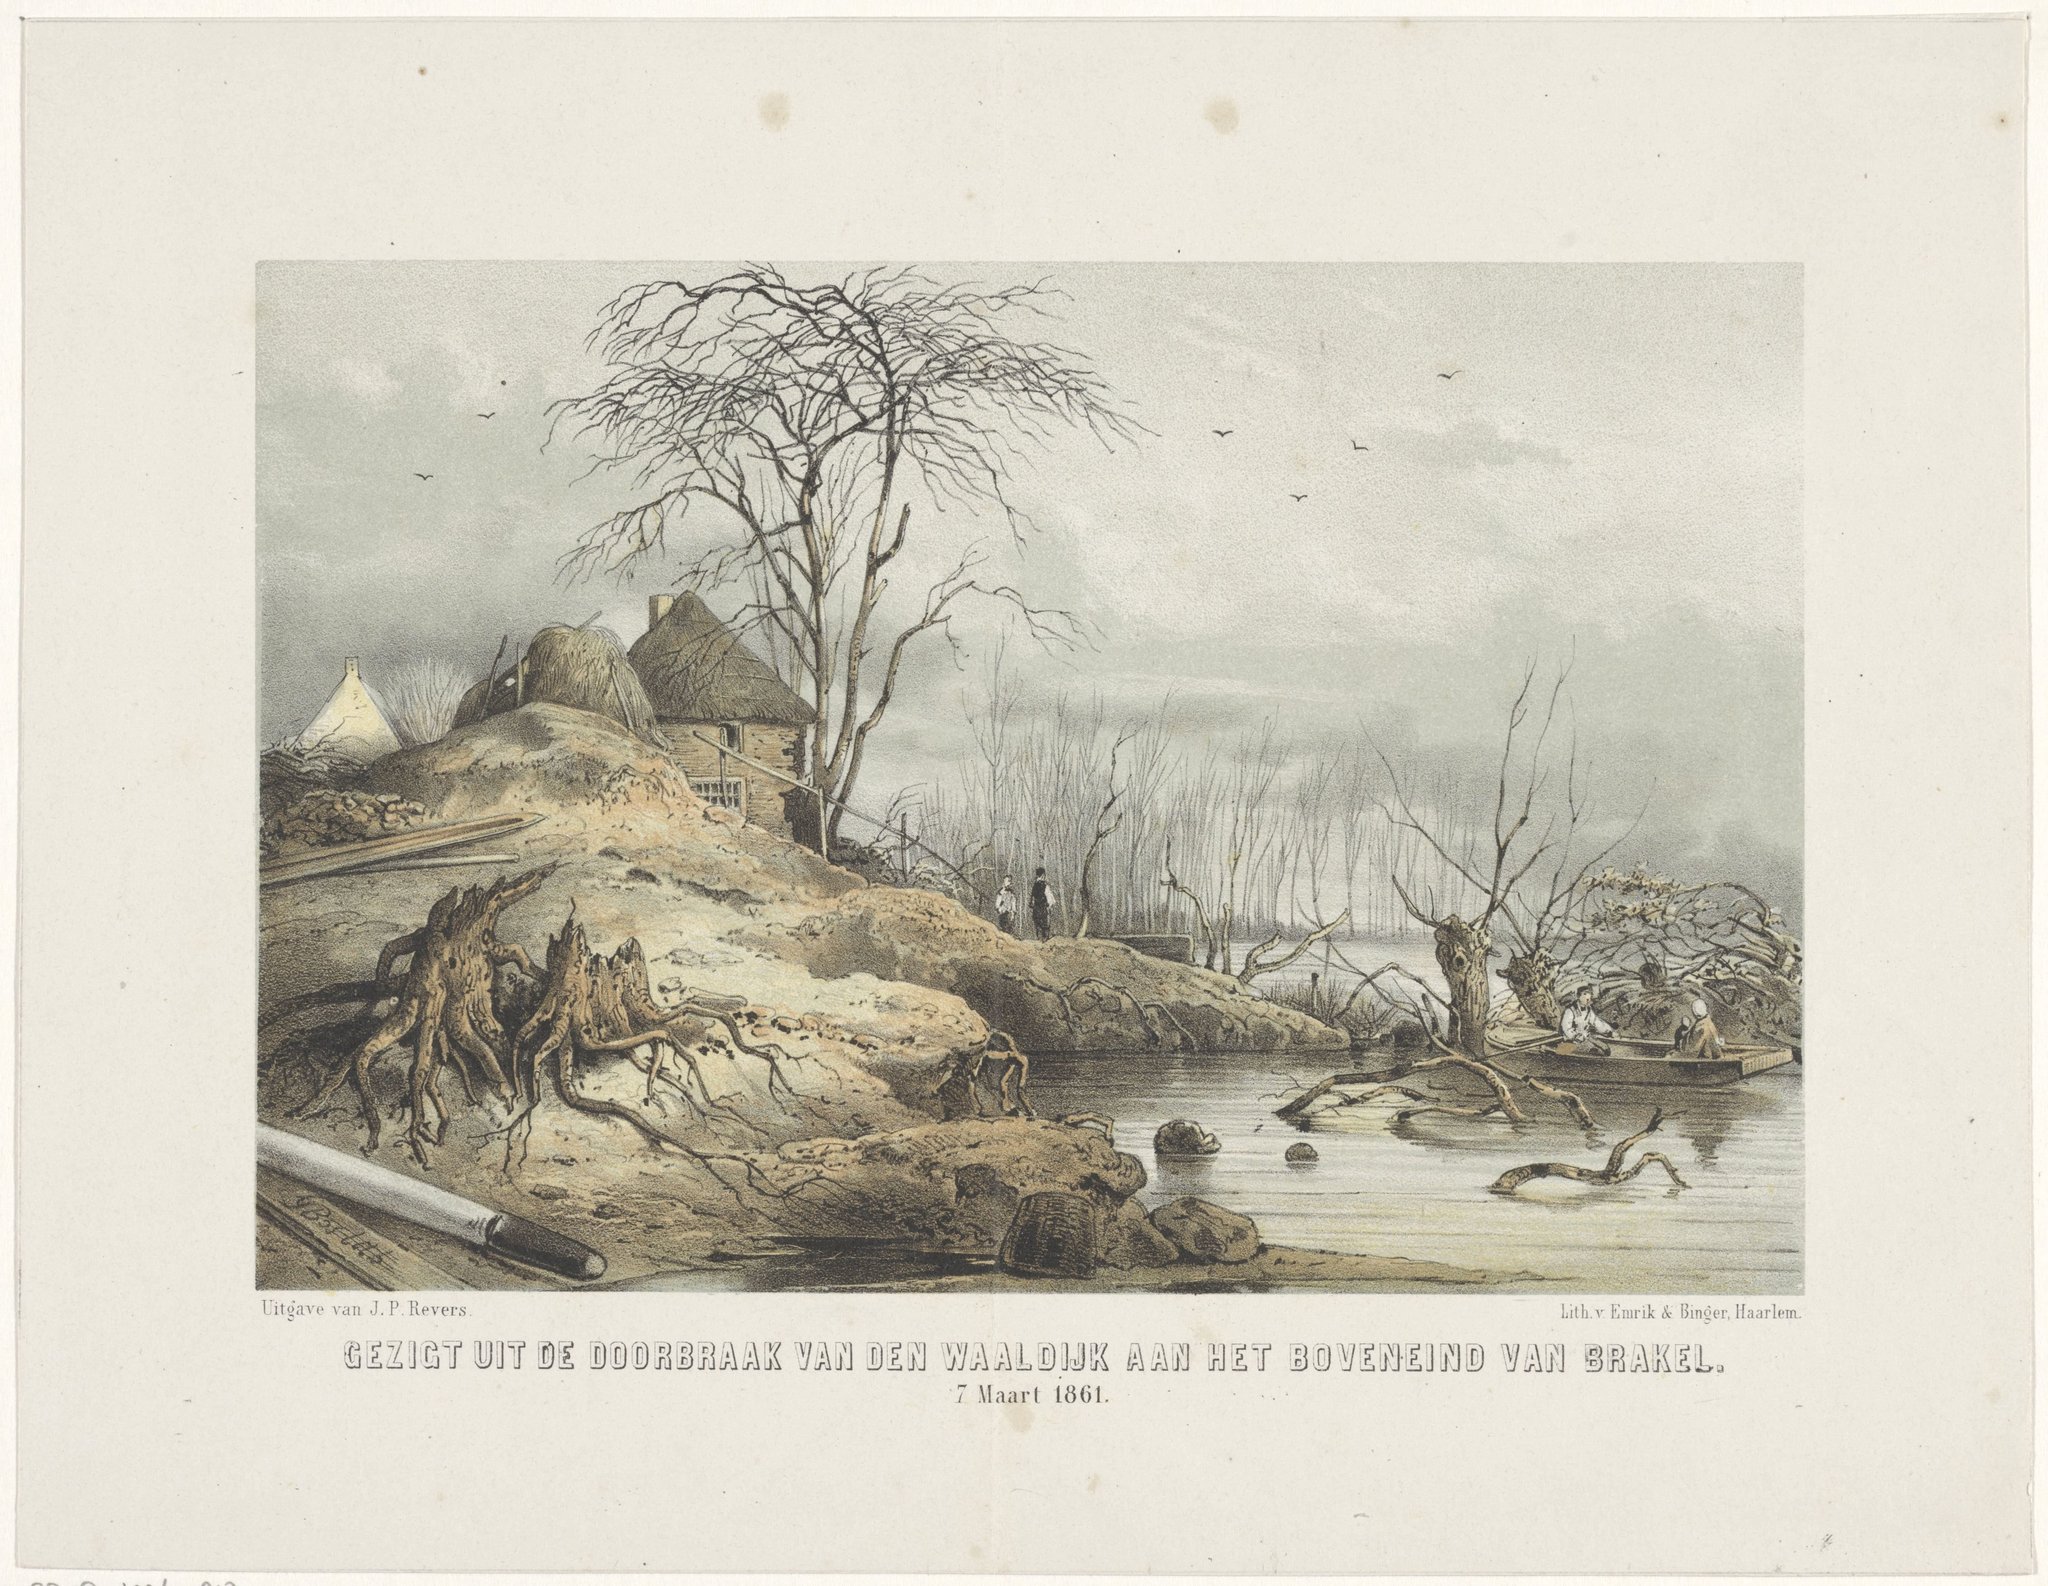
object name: print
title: Doorbraak van de Waaldijk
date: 1835-1898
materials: paper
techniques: lithograph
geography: netherlands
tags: trees (+ root, tuber), rowing facing backward, pulling, dike-break (+ landscape with figures, staffage)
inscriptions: collector's mark: Lugt 2228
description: Op het land liggen ontwortelde en kapotte bomen en stukken hout. Enkele bomen staan onderwater. Op het water vaart een roeiboot met twee figuren. Links op een heuvel staat een huis met een hooischuur.